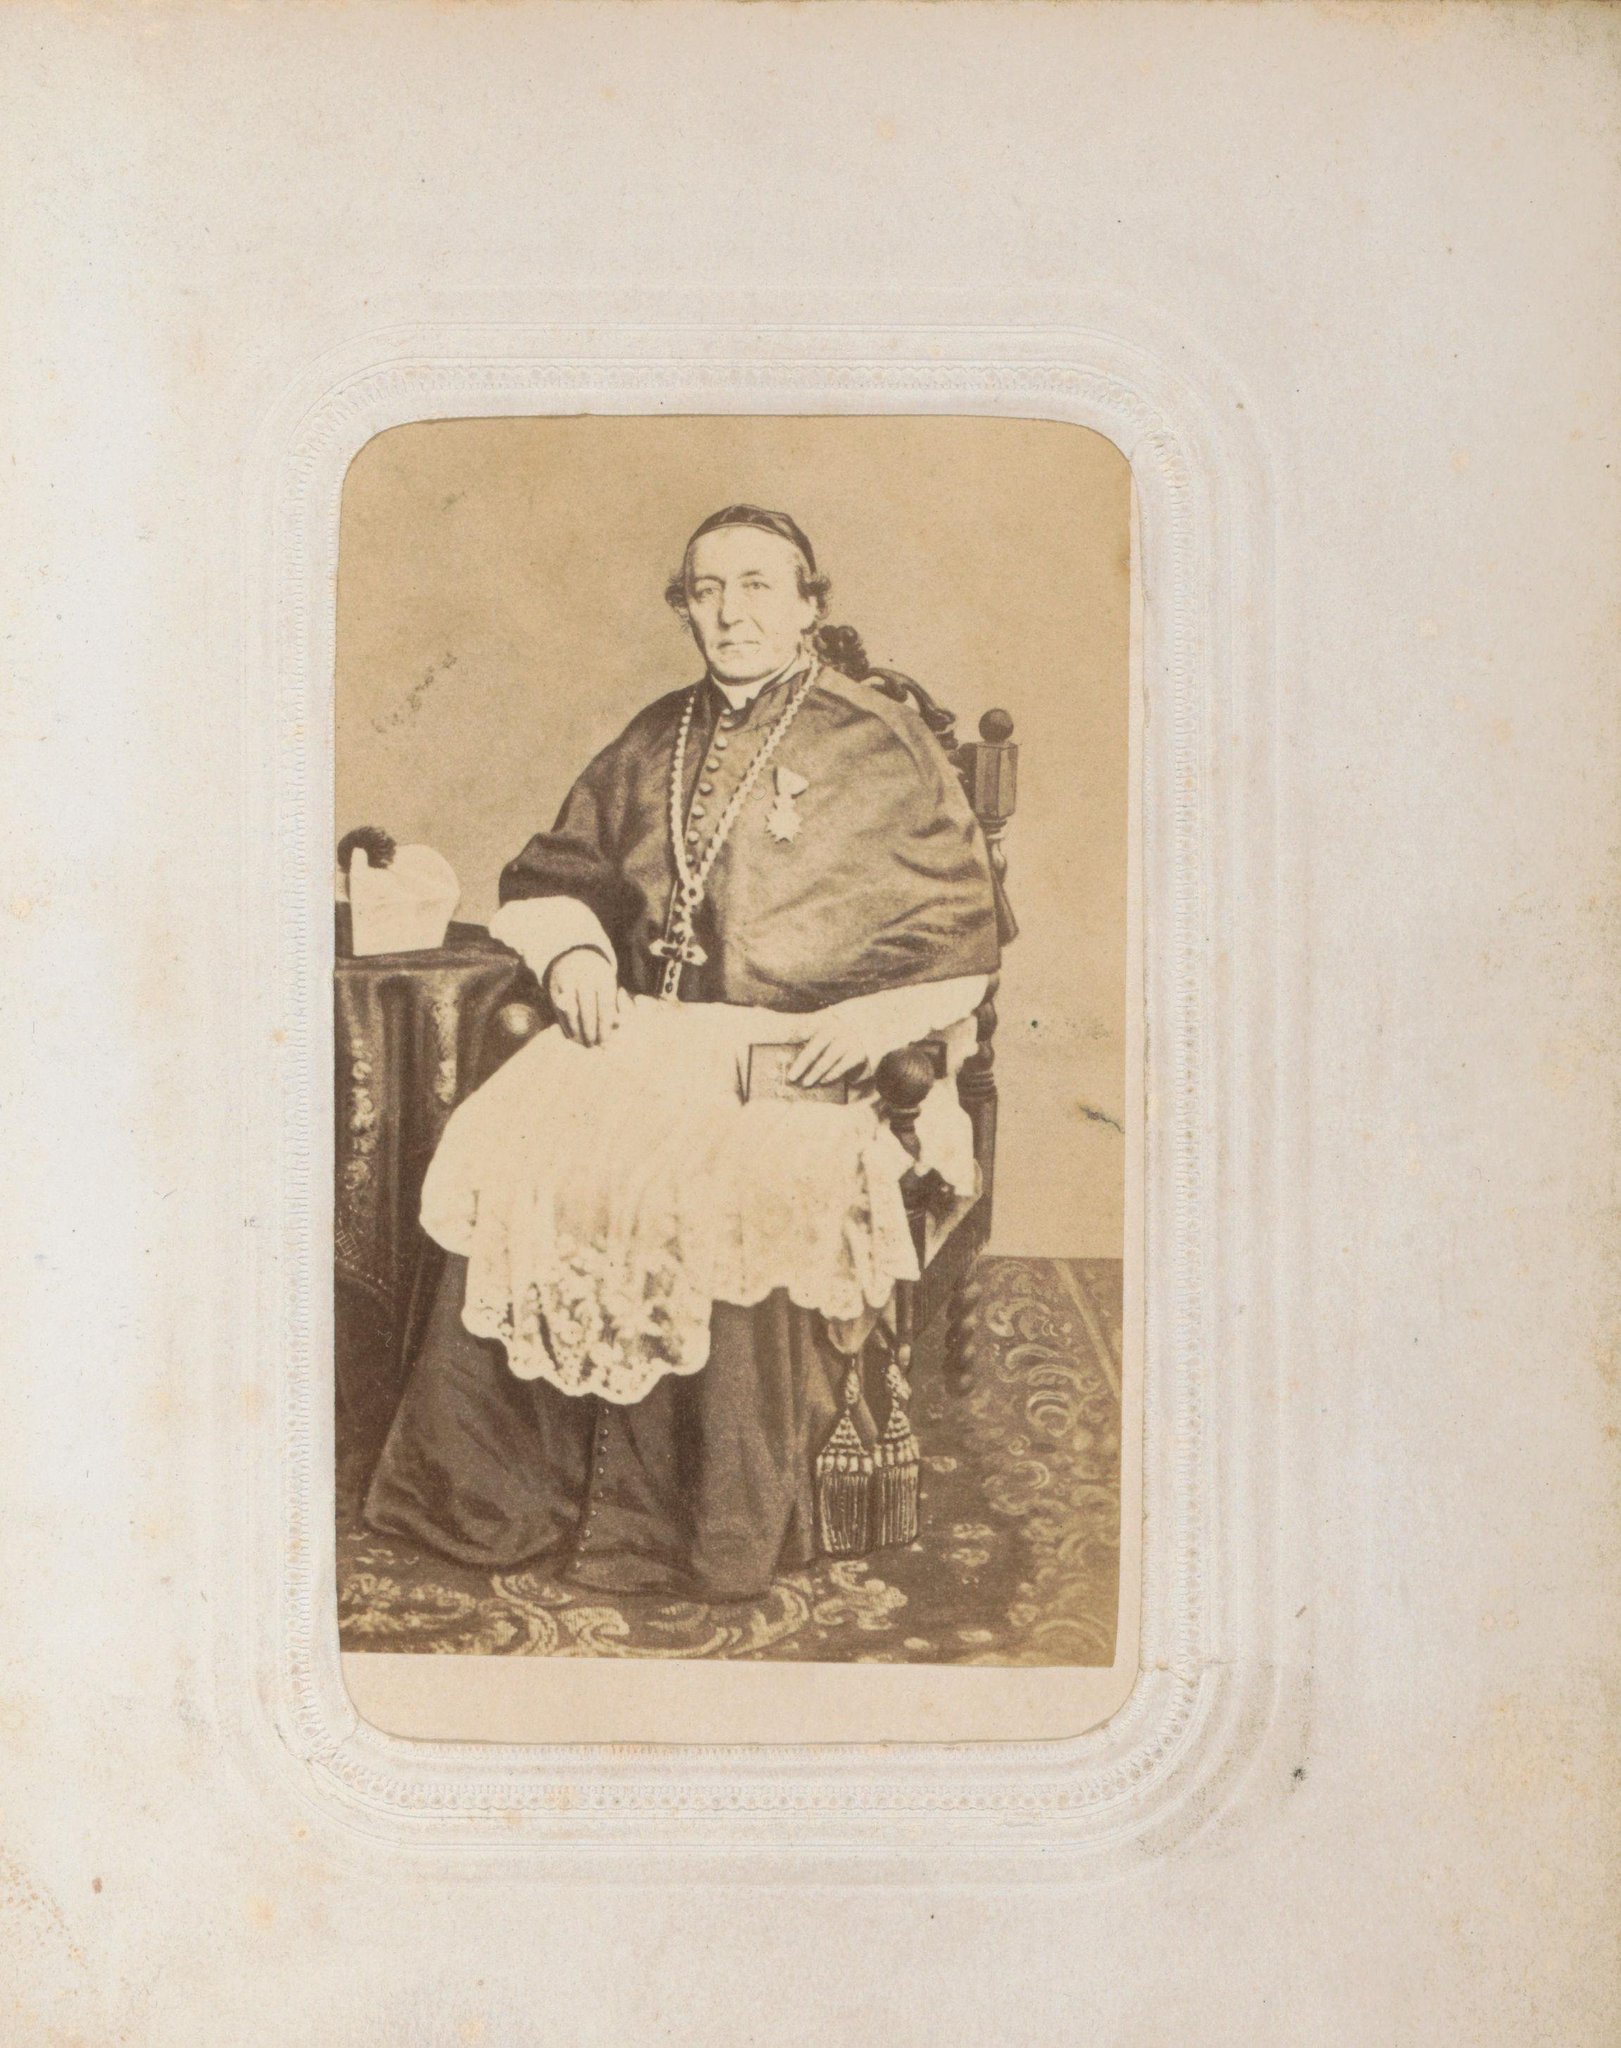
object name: photograph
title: Portret van bisschop Wilmer van Haarlem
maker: Anonymous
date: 1860-1877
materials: cardboard, paper, photographic support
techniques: albumen print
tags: gerardus petrus wilmer, archbishop, bishop, etc. (roman catholic)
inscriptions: name: ‘Wilmers’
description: Portret van bisschop Wilmer van Haarlem met een boek in de hand. Om zijn nek een kruis, op het hoofd een biretta. Van Haarlem draagt over zijn toog een halflange witte superplie, met daar overheen een pelerine. Onderdeel van Fotoalbum met 26 cartes-de-visite van rooms-katholieke geestelijken.